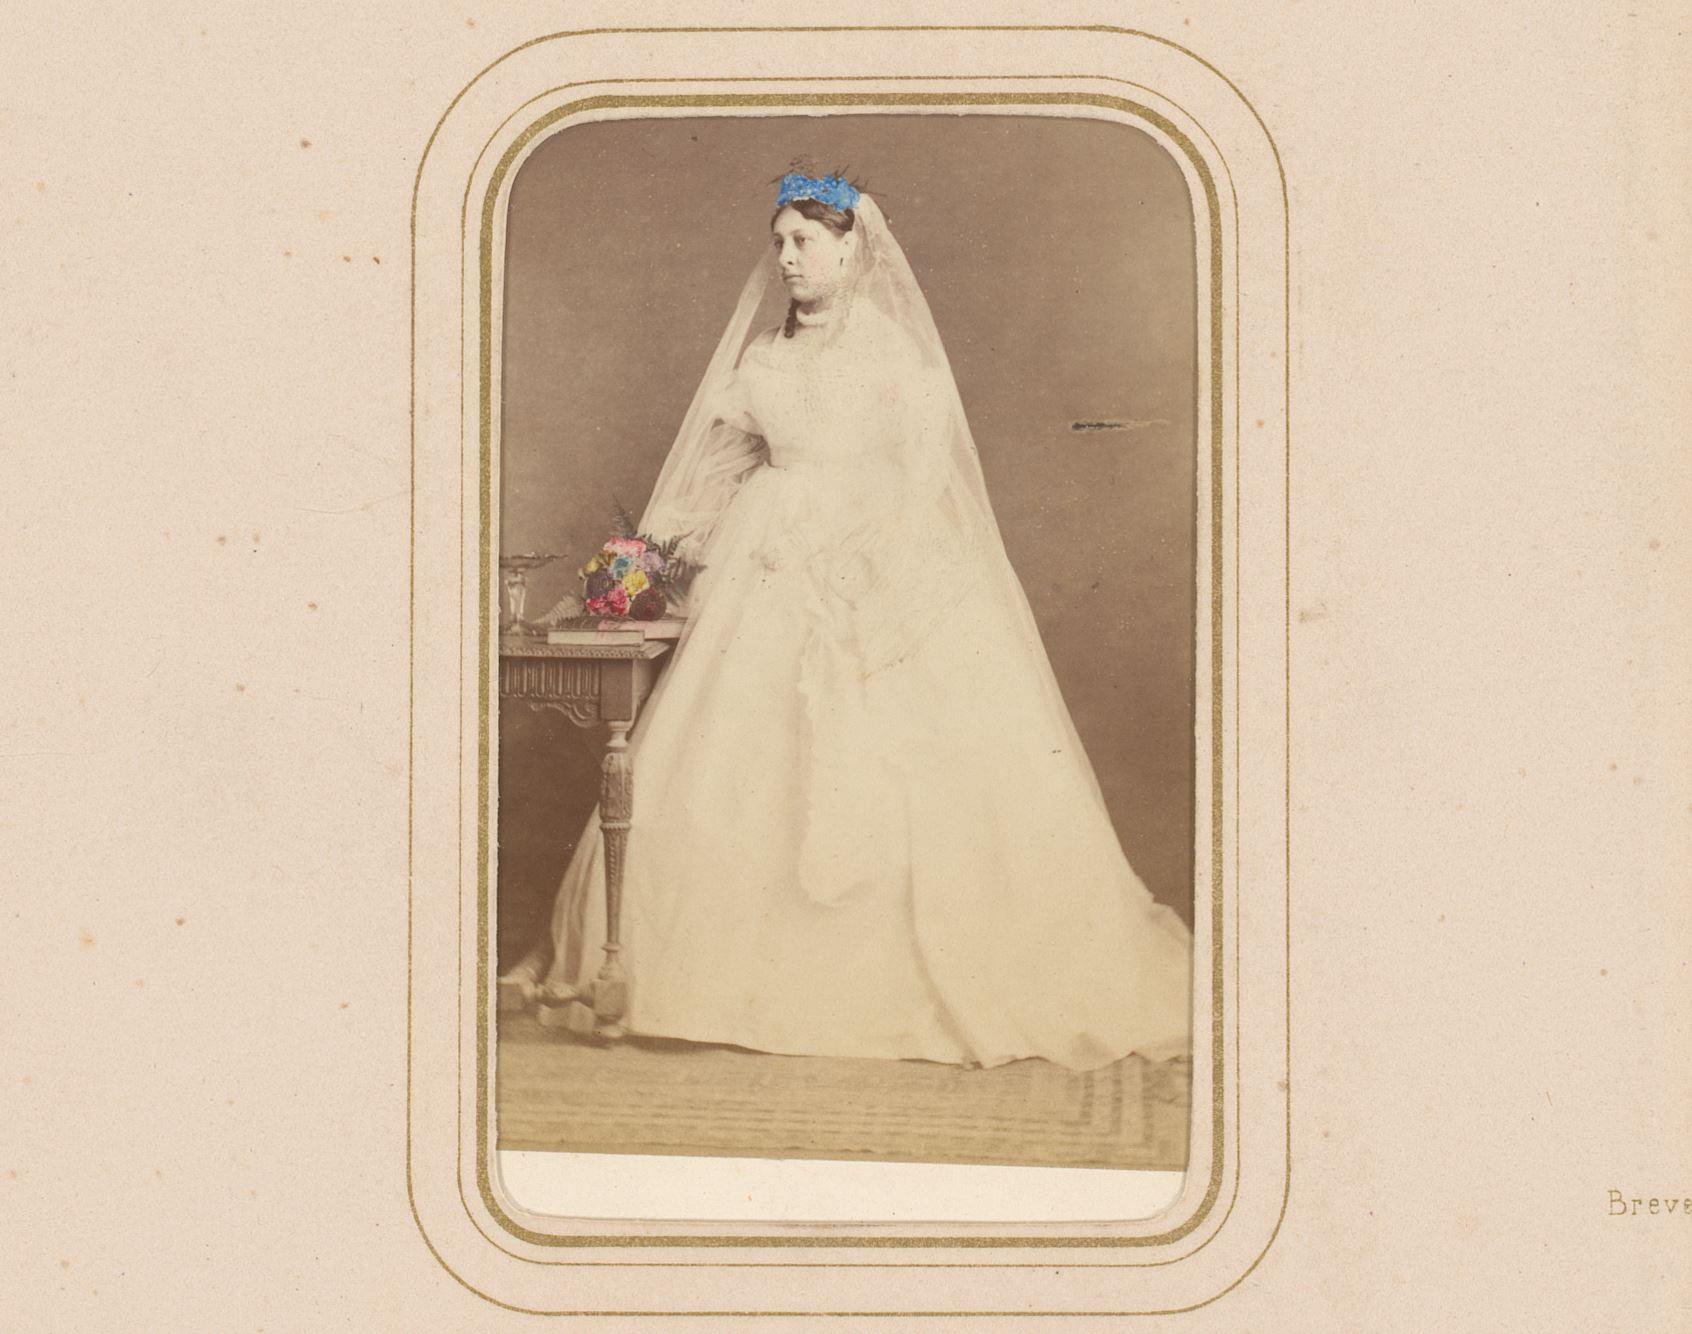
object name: album leaf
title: Portret van een staande vrouw in bruidsjurk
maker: robert faulkner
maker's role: fotograaf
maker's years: 1823-1890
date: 1850-1890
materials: cardboard, photographic support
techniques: albumen print, hand coloring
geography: london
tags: historical persons - bb - woman, standing figure - aa - female human figure, bride (in wedding-dress)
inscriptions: inscription: ‘ROBERT FAULKNER,/ PORTRAIT PAINTER & PHOTOGRAPHER,/ 46, KENSINGTON GARDENS SQUARE,/ WESTBOURNE GROVE,/ BAYSWATER, W.’, date: ‘1943’